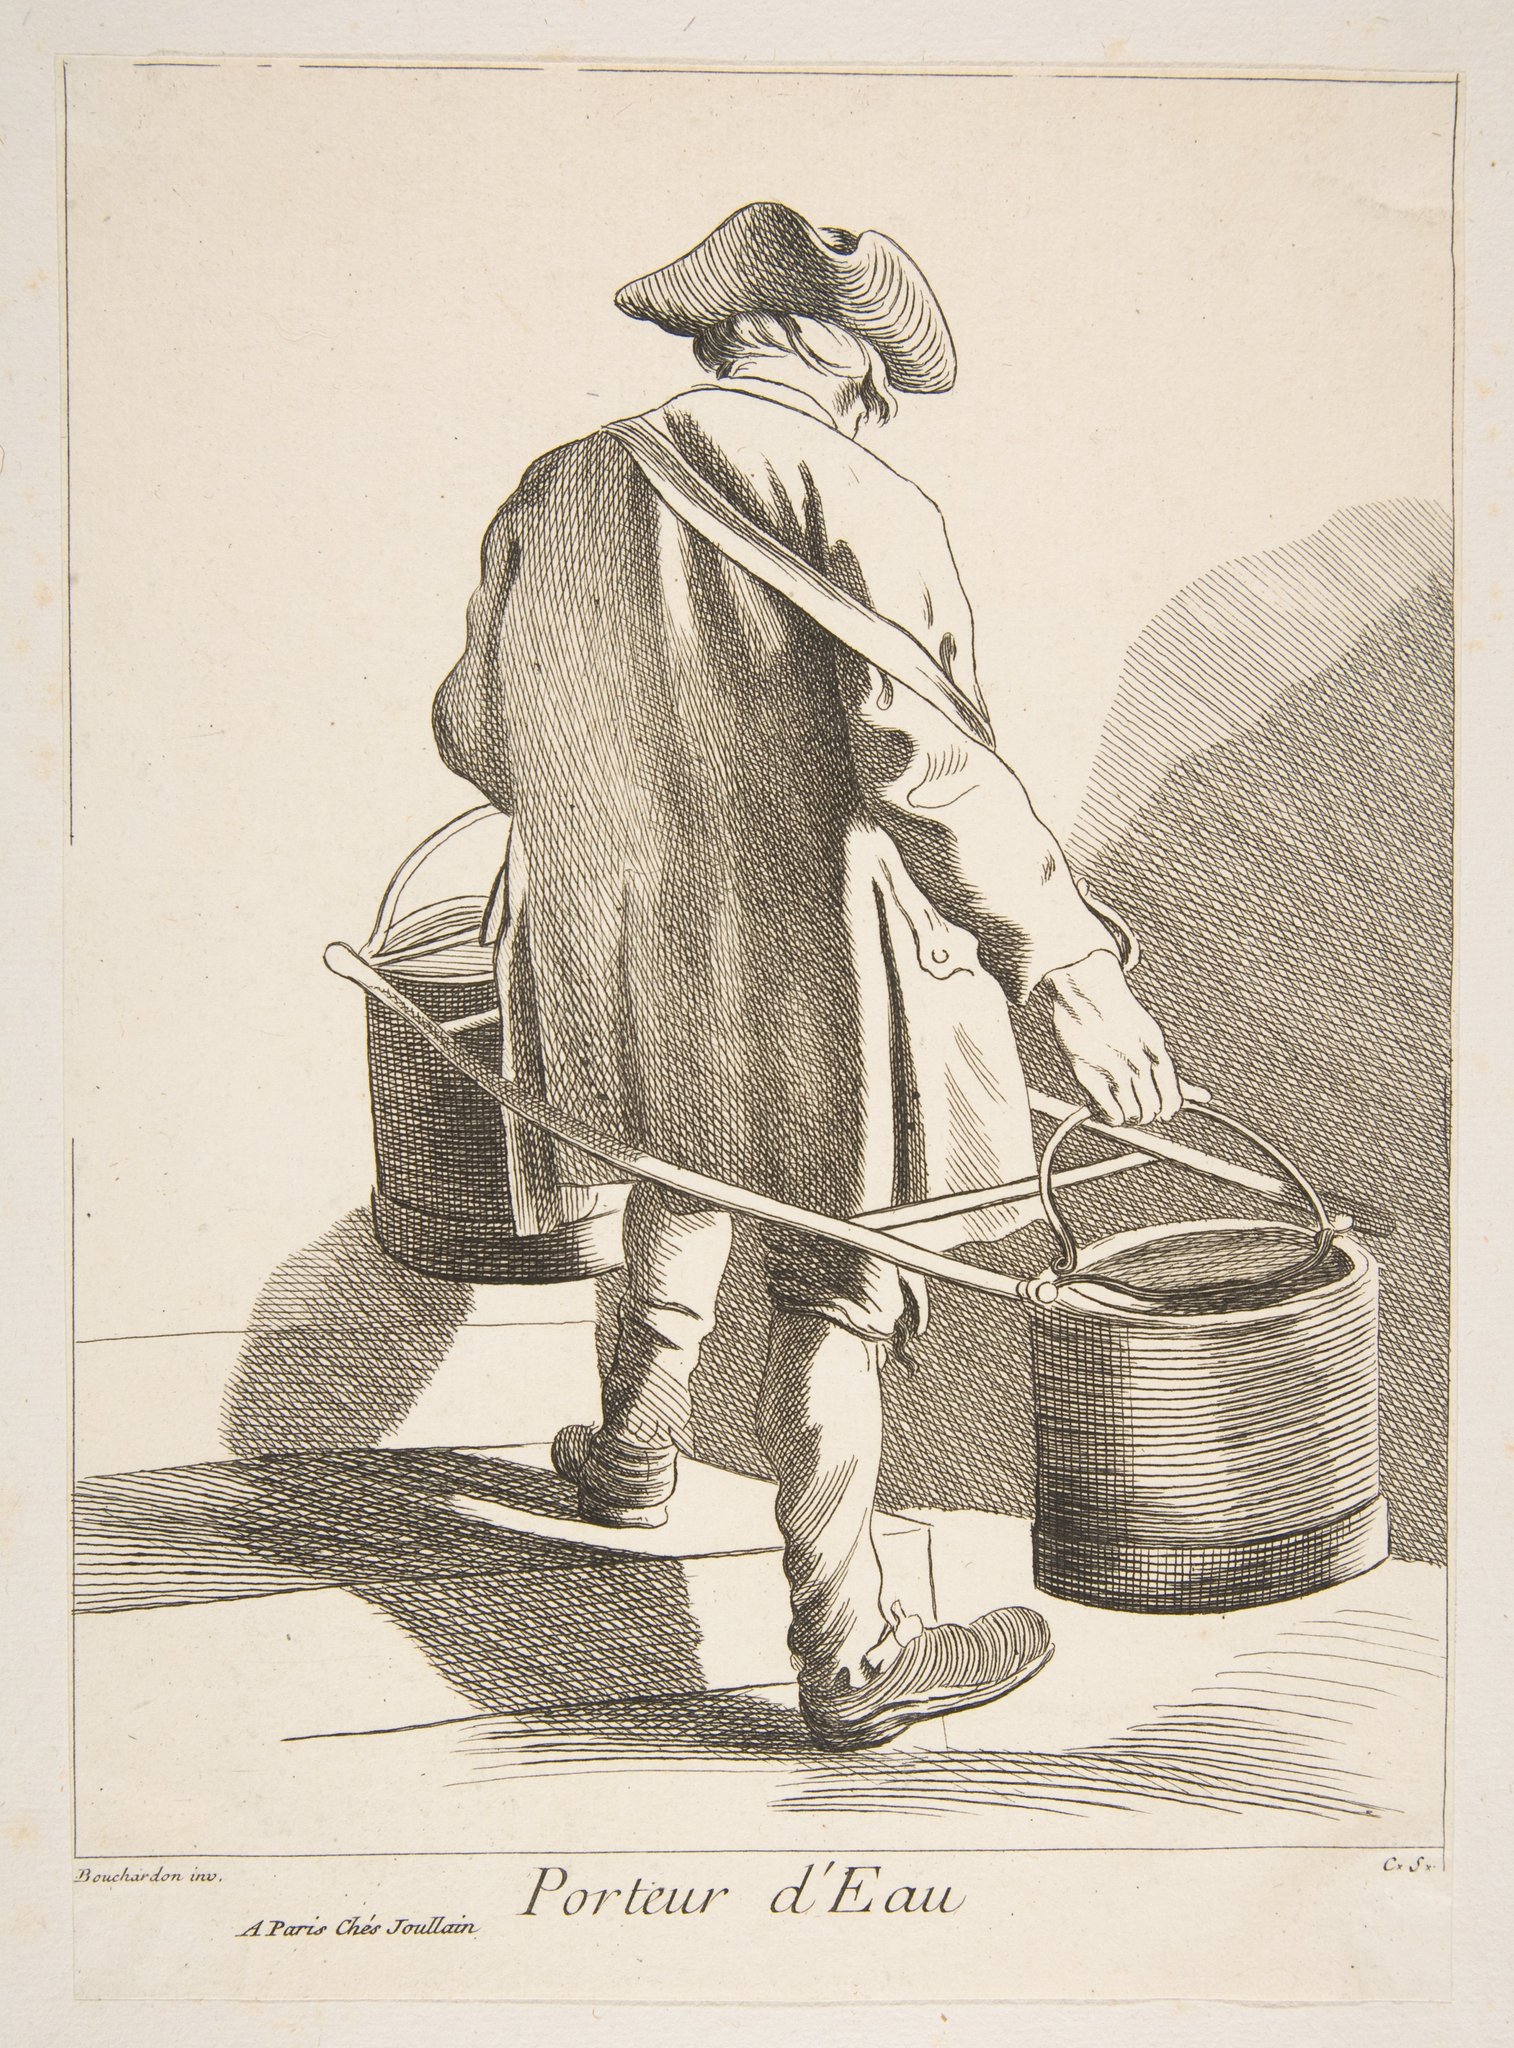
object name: print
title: Water Carrier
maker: anne claude philippe de tubières, comte de caylus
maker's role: artist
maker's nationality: french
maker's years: 1692-1765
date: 1742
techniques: engraving, etching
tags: men